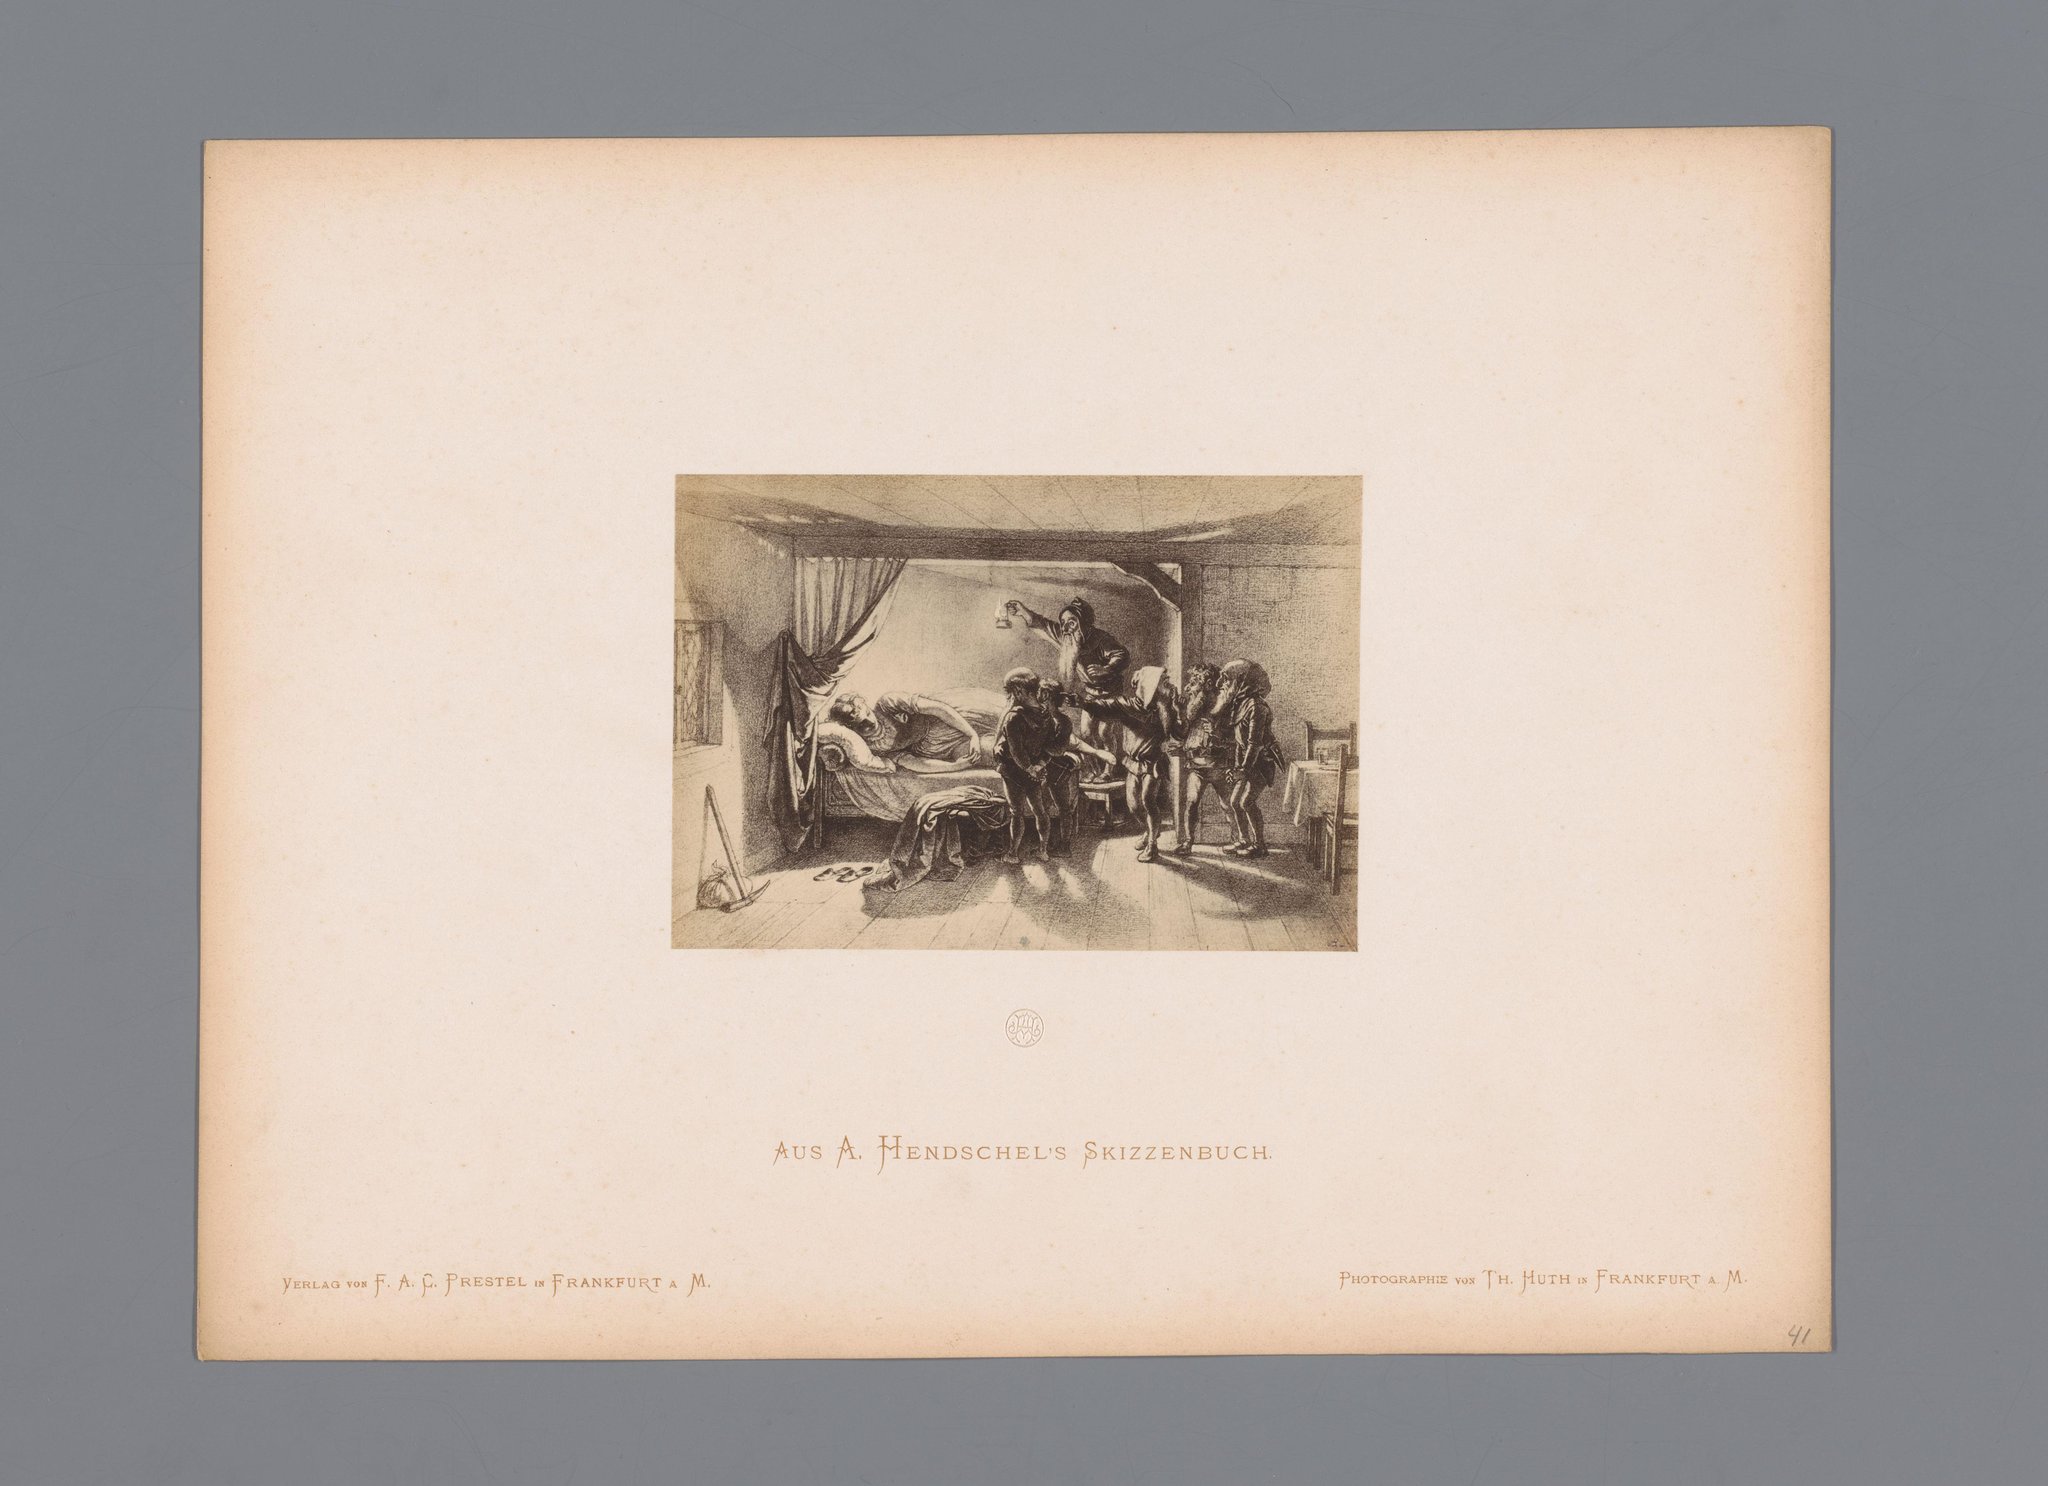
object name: photograph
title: Fotoreproductie van een schets van Sneeuwwitje bij de zeven dwergen door Albert Hendschel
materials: photographic support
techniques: albumen print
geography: frankfurt am main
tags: tales and fairy tales: sleeping beauty, sleeping in bed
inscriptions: monogram: ‘AH’, number: ‘41’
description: Deze foto maakt deel uit van een omslag met 50 foto's op 48 bladen, een lijst van afbeeldingen en een titelblad.